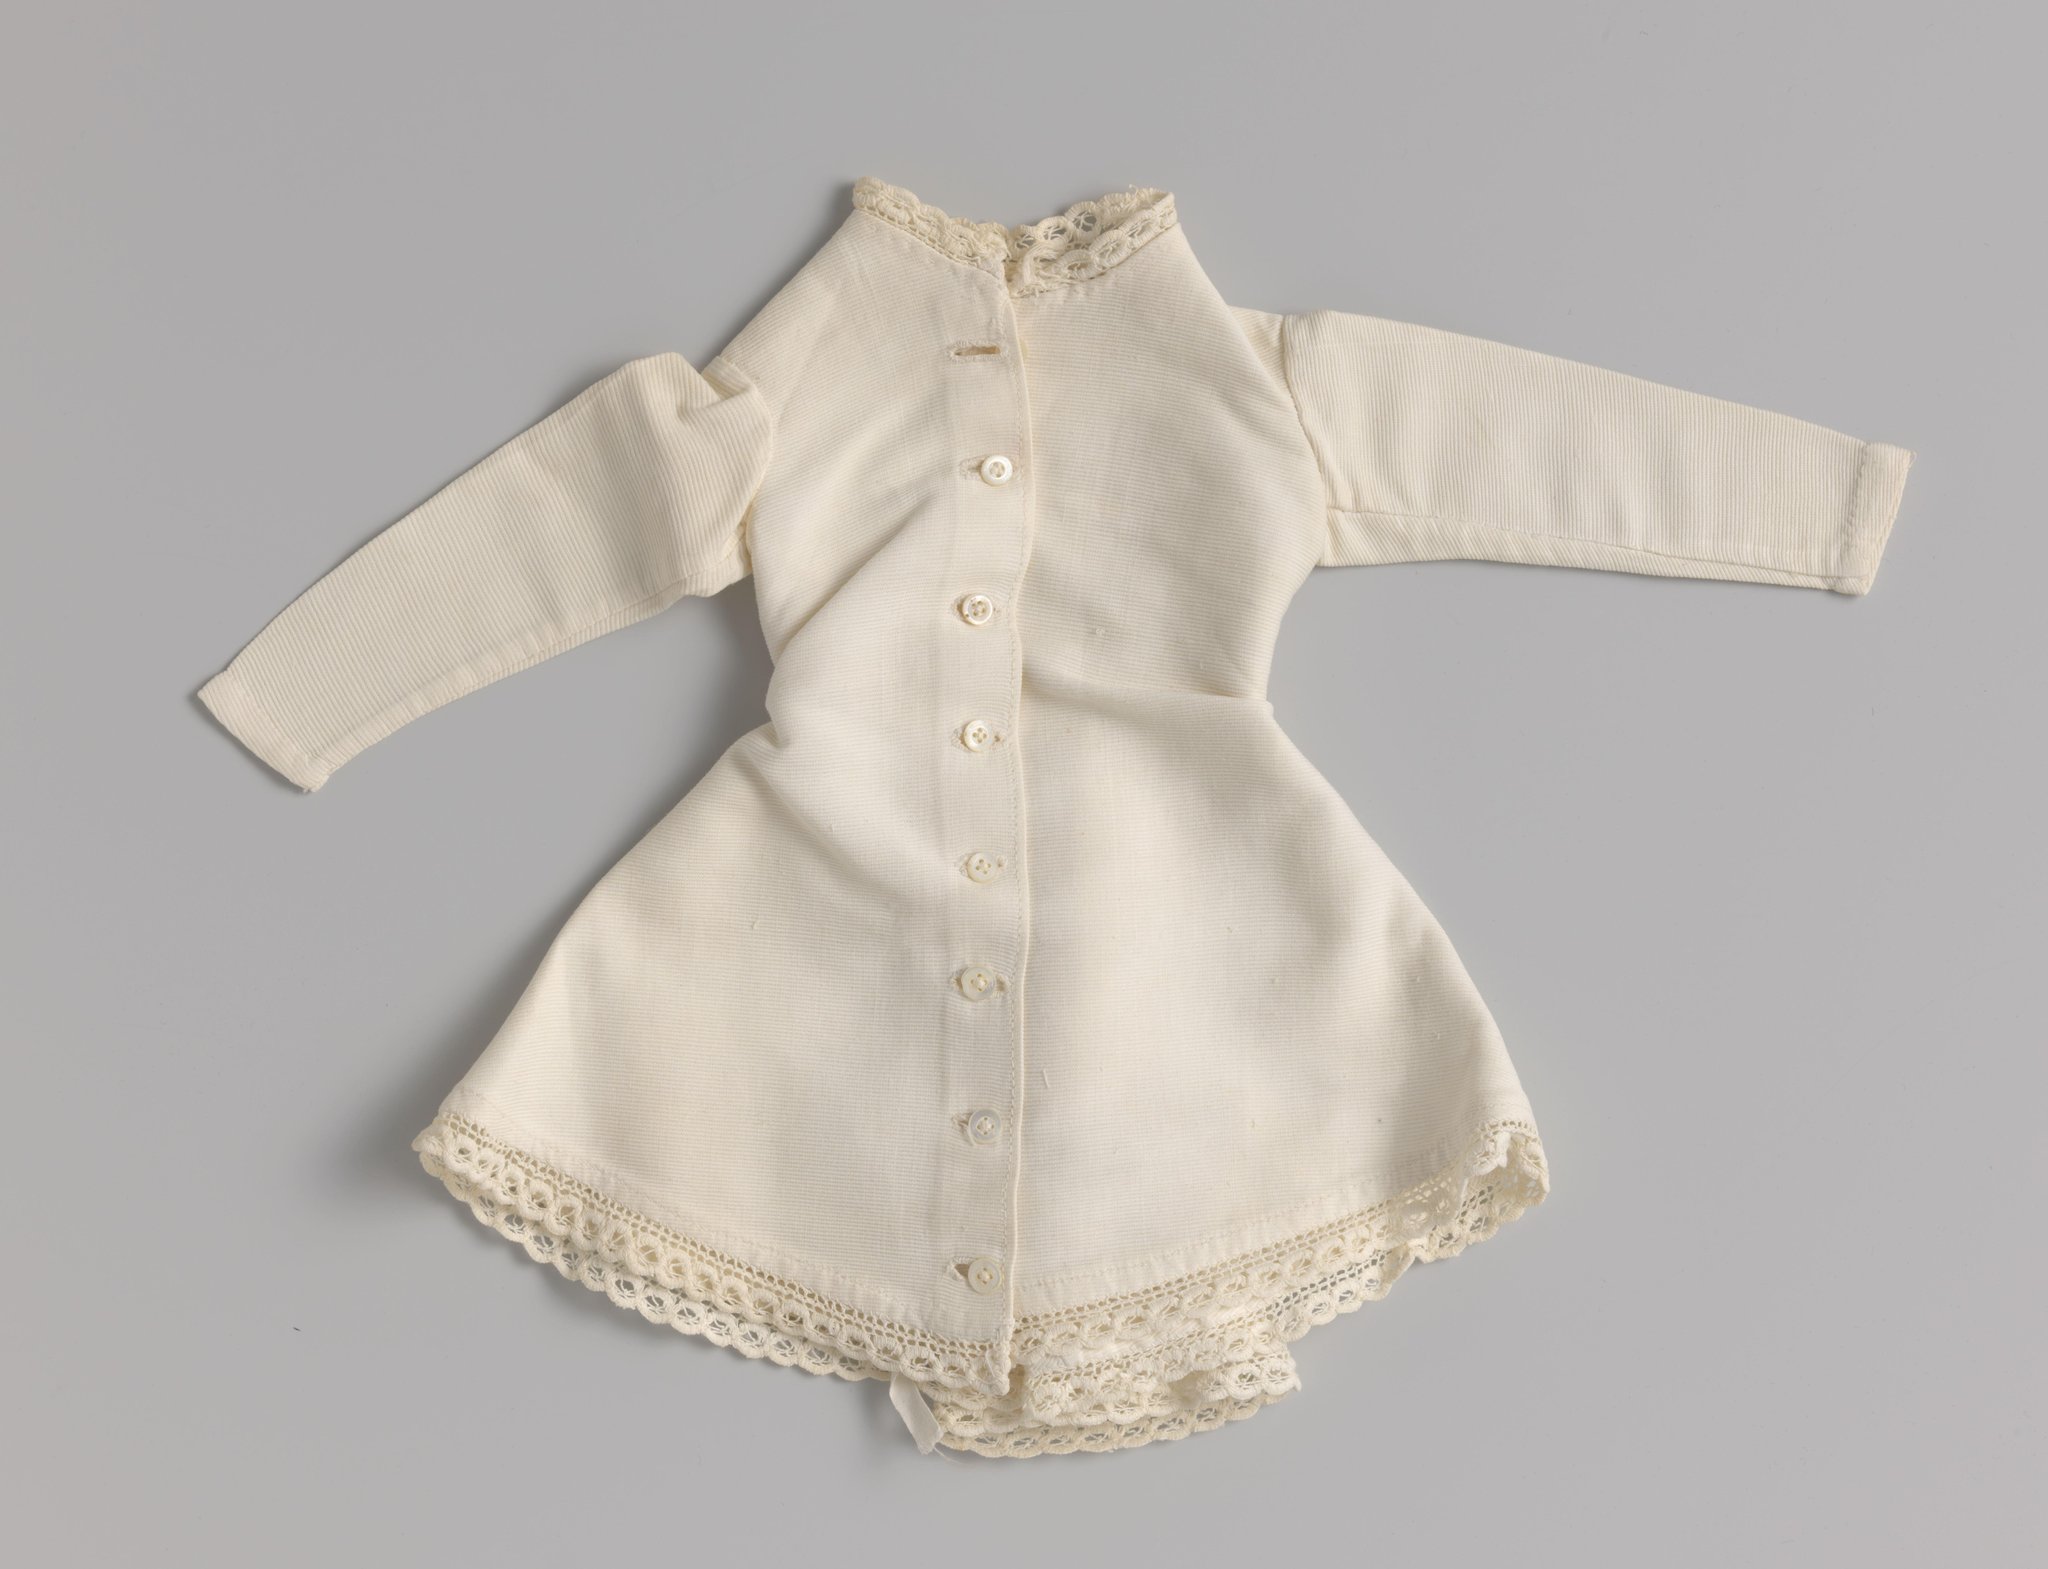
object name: doll's clothing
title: Tuniek met knoopsluiting van wit katoenen piqué, onderdeel van een poppenjurk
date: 1870-1875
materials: cotton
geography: netherlands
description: Tuniek van wit katoenen piqué met knoopsluiting aan de voorzijde, hoge ronde hals, lange gladde mouwen, rugpand bovenaan in vliegervorm en onderaan wijduitlopend in een geplooide schoot, die ruimte biedt voor een queue. Aan de binnenzijde een insnoerbandje. Langs de hals en zoom is een machinaal kantje aangenaaid.